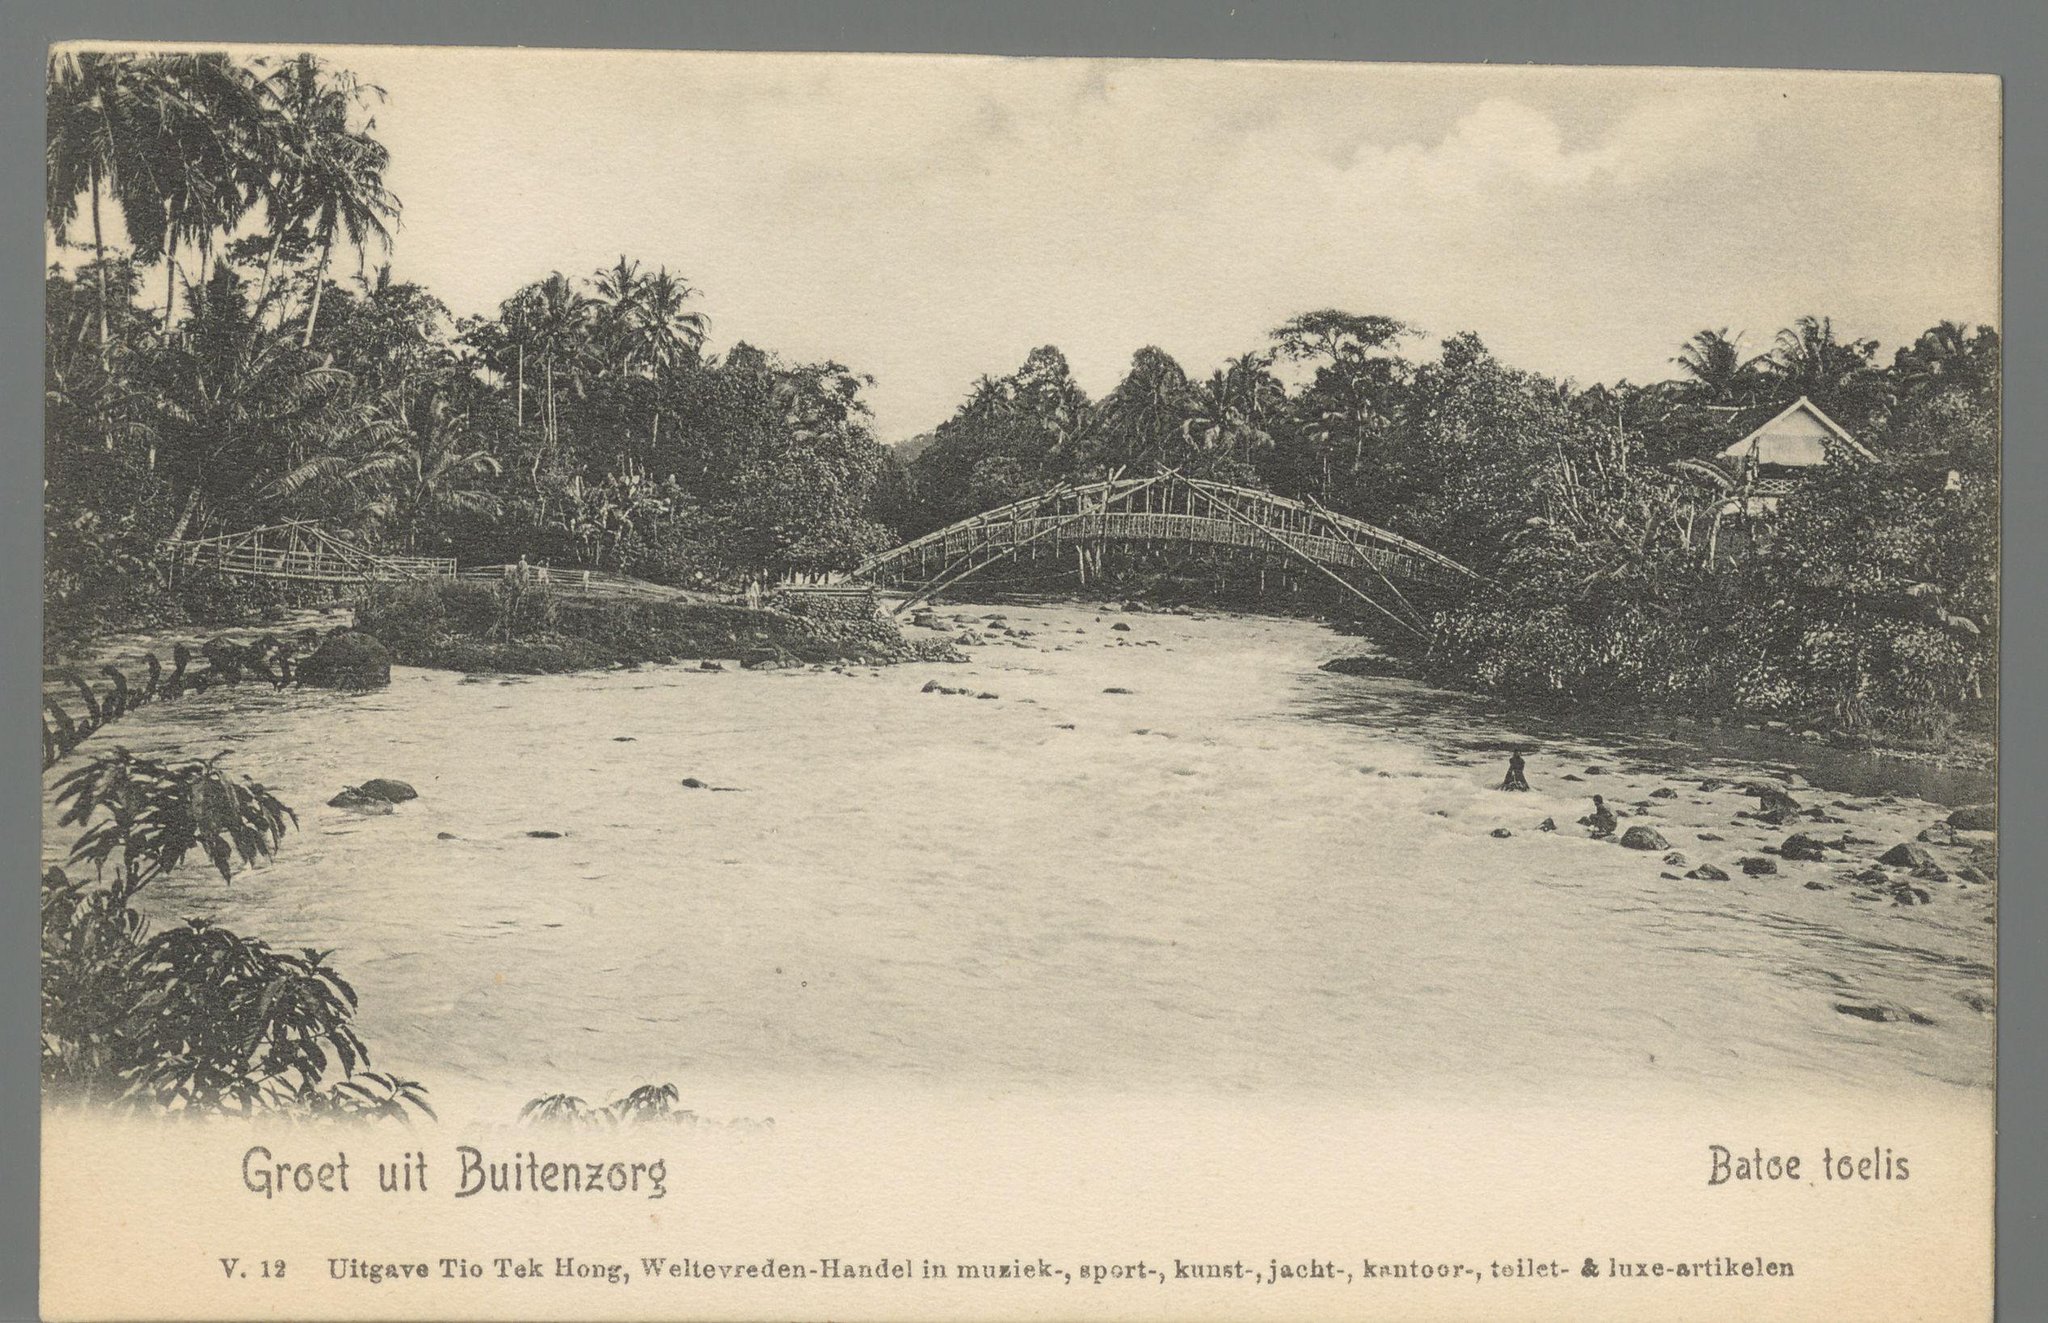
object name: ansichtkaart, prentbriefkaart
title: Groet uit Buitenzorg. Batoe toelis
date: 1906-1930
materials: cardboard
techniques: photograph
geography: weltevreden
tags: river, bridge